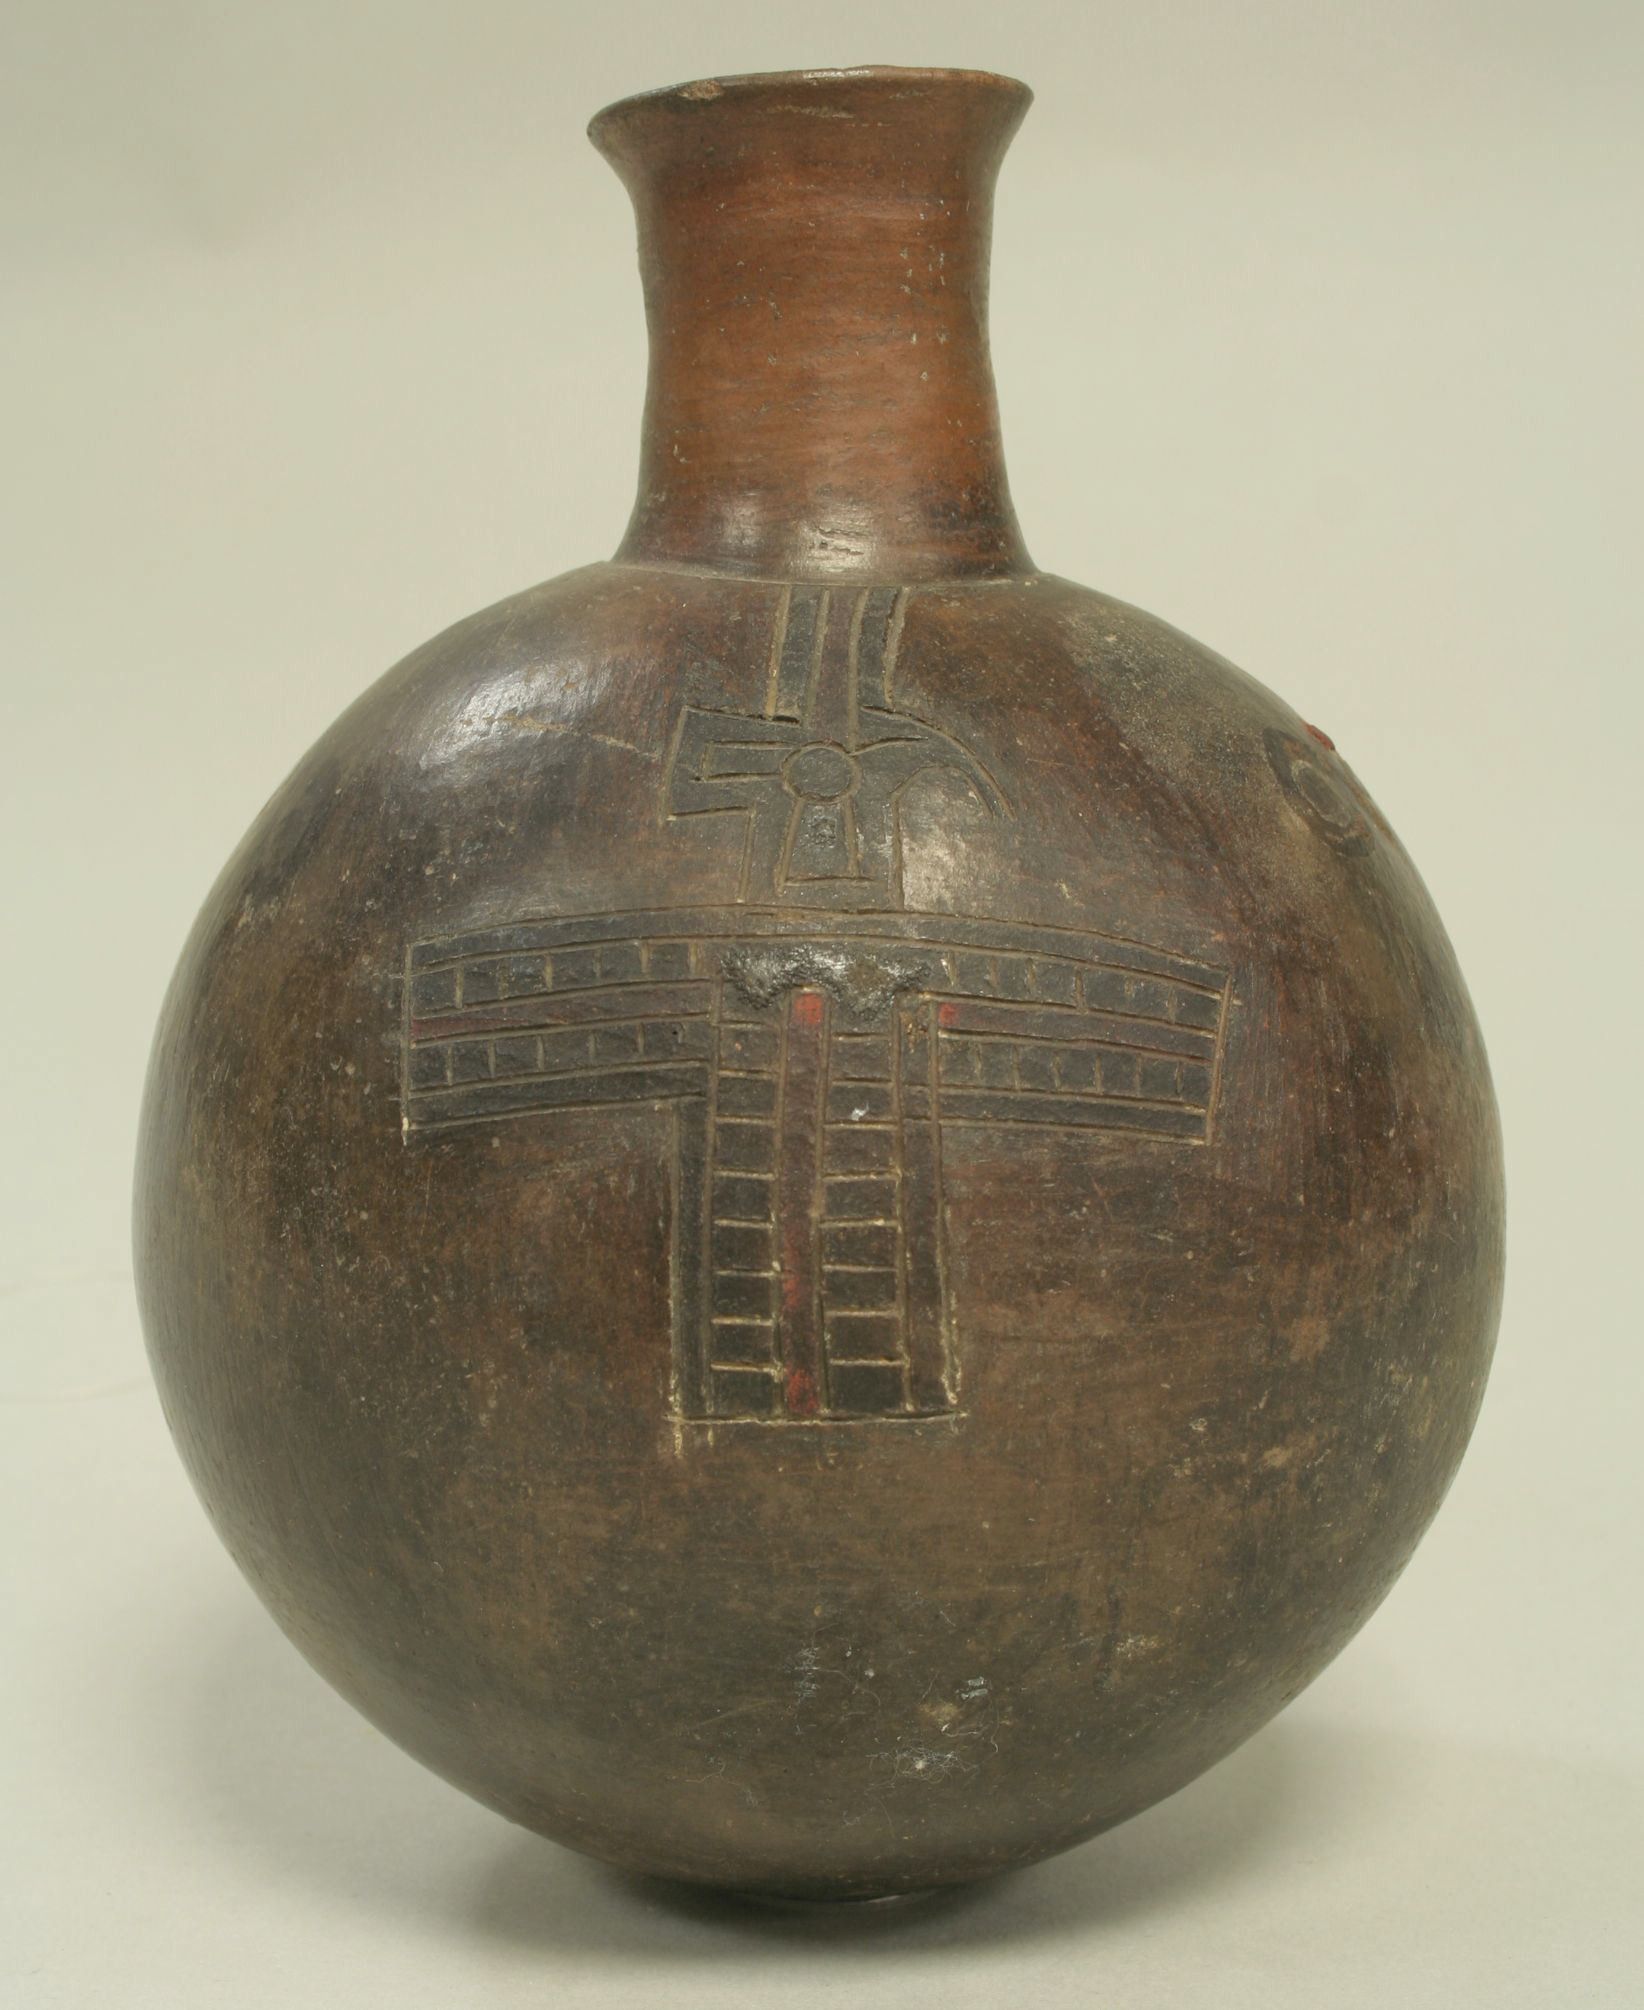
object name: bottle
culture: paracas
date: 700-301 BCE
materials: ceramic, paint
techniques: firing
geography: peru